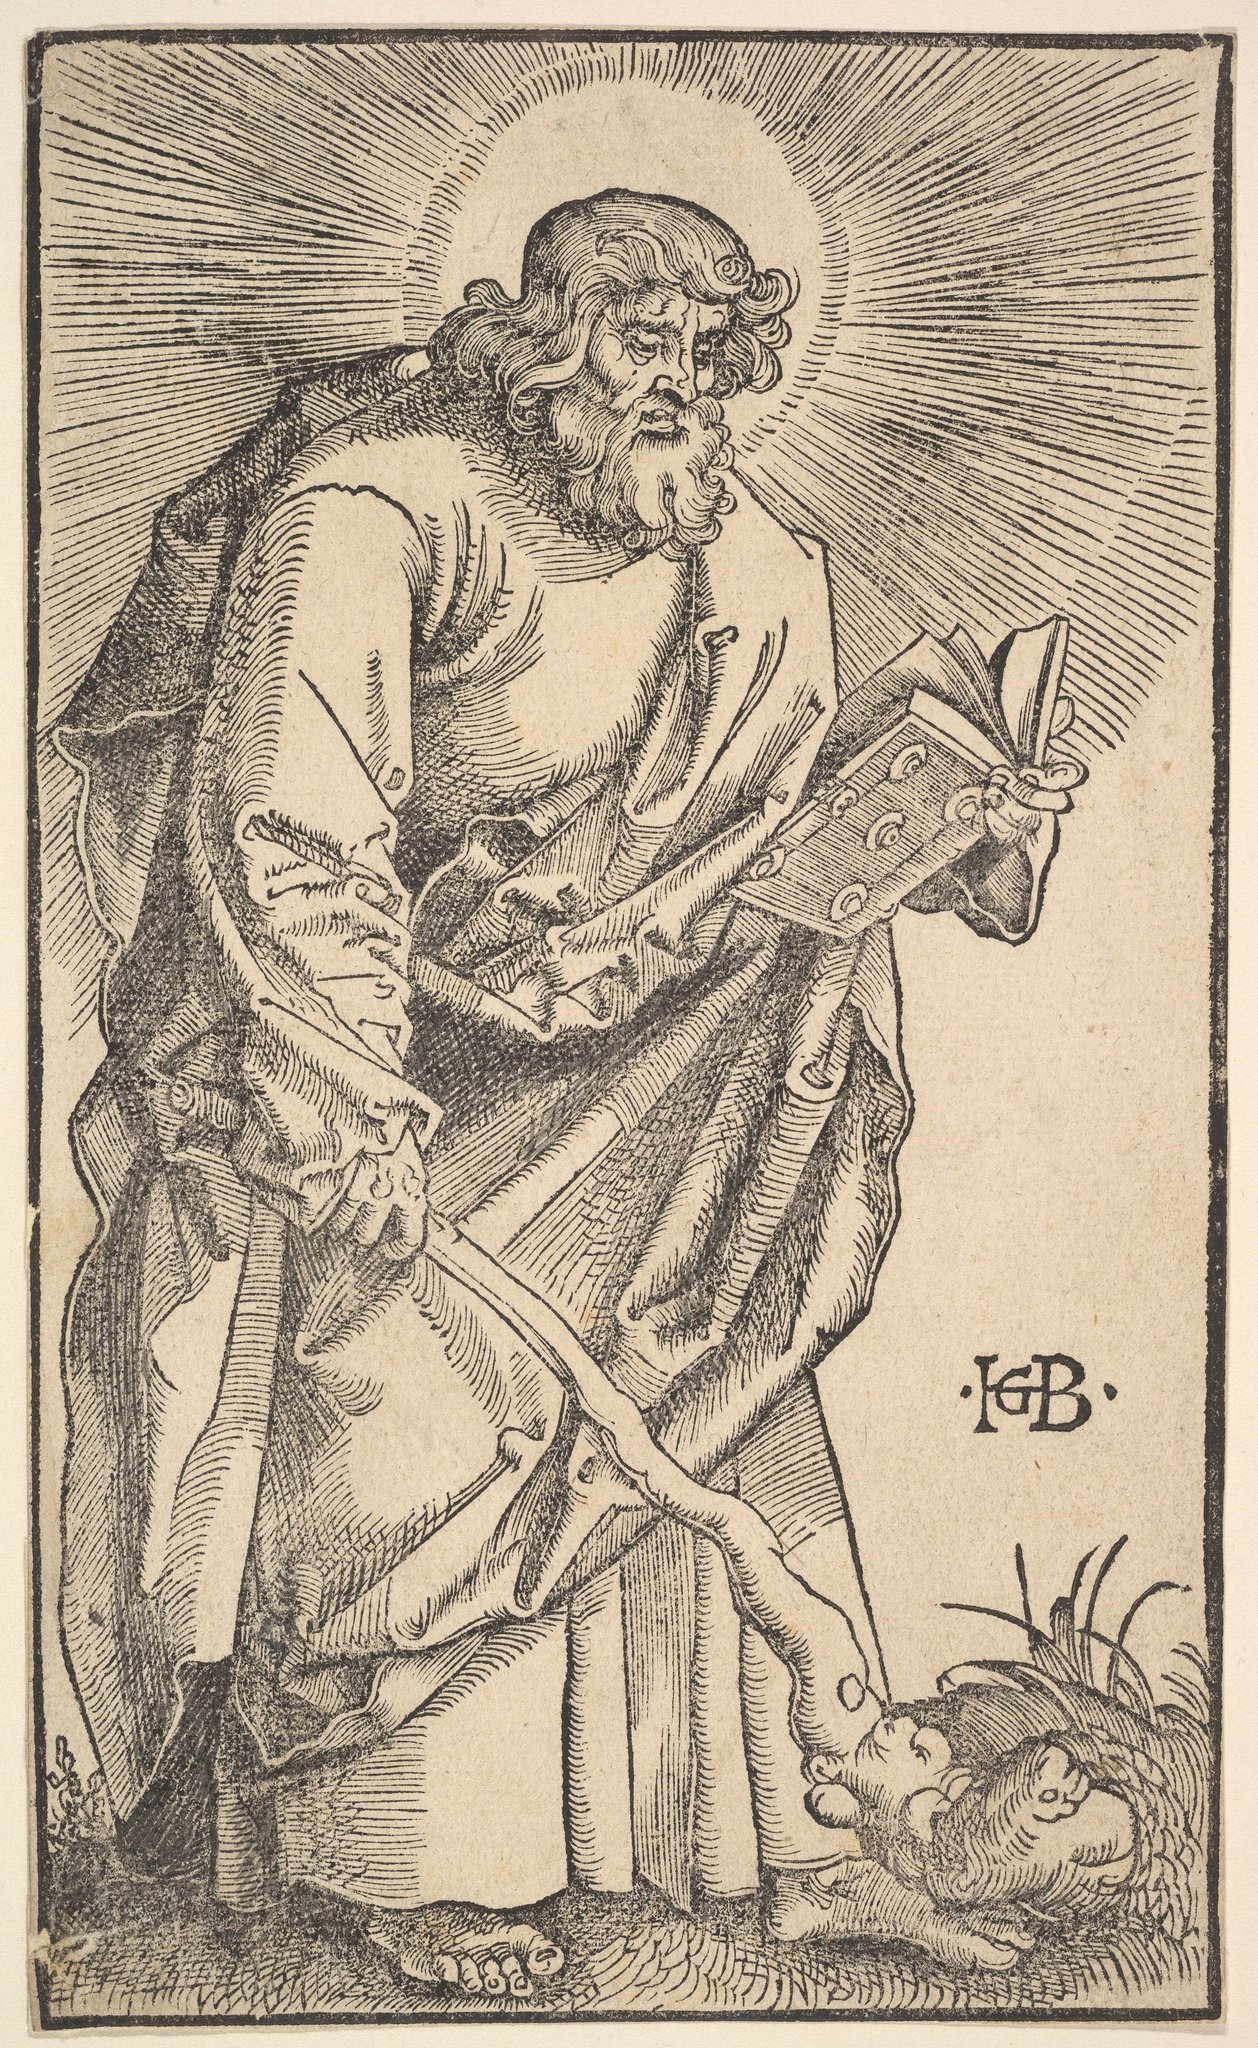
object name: print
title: St. Judas Thaddaeus, from "Christ and the Apostles"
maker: hans baldung (called hans baldung grien)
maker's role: artist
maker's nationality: german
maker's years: 1484-1545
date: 1519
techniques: woodcut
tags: saints